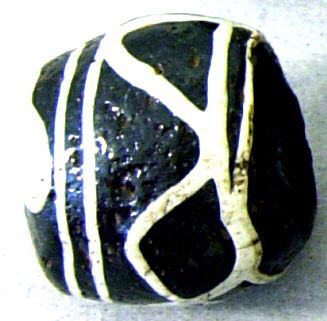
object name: bead, string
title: String of Beads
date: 801-1900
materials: glass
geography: egypt